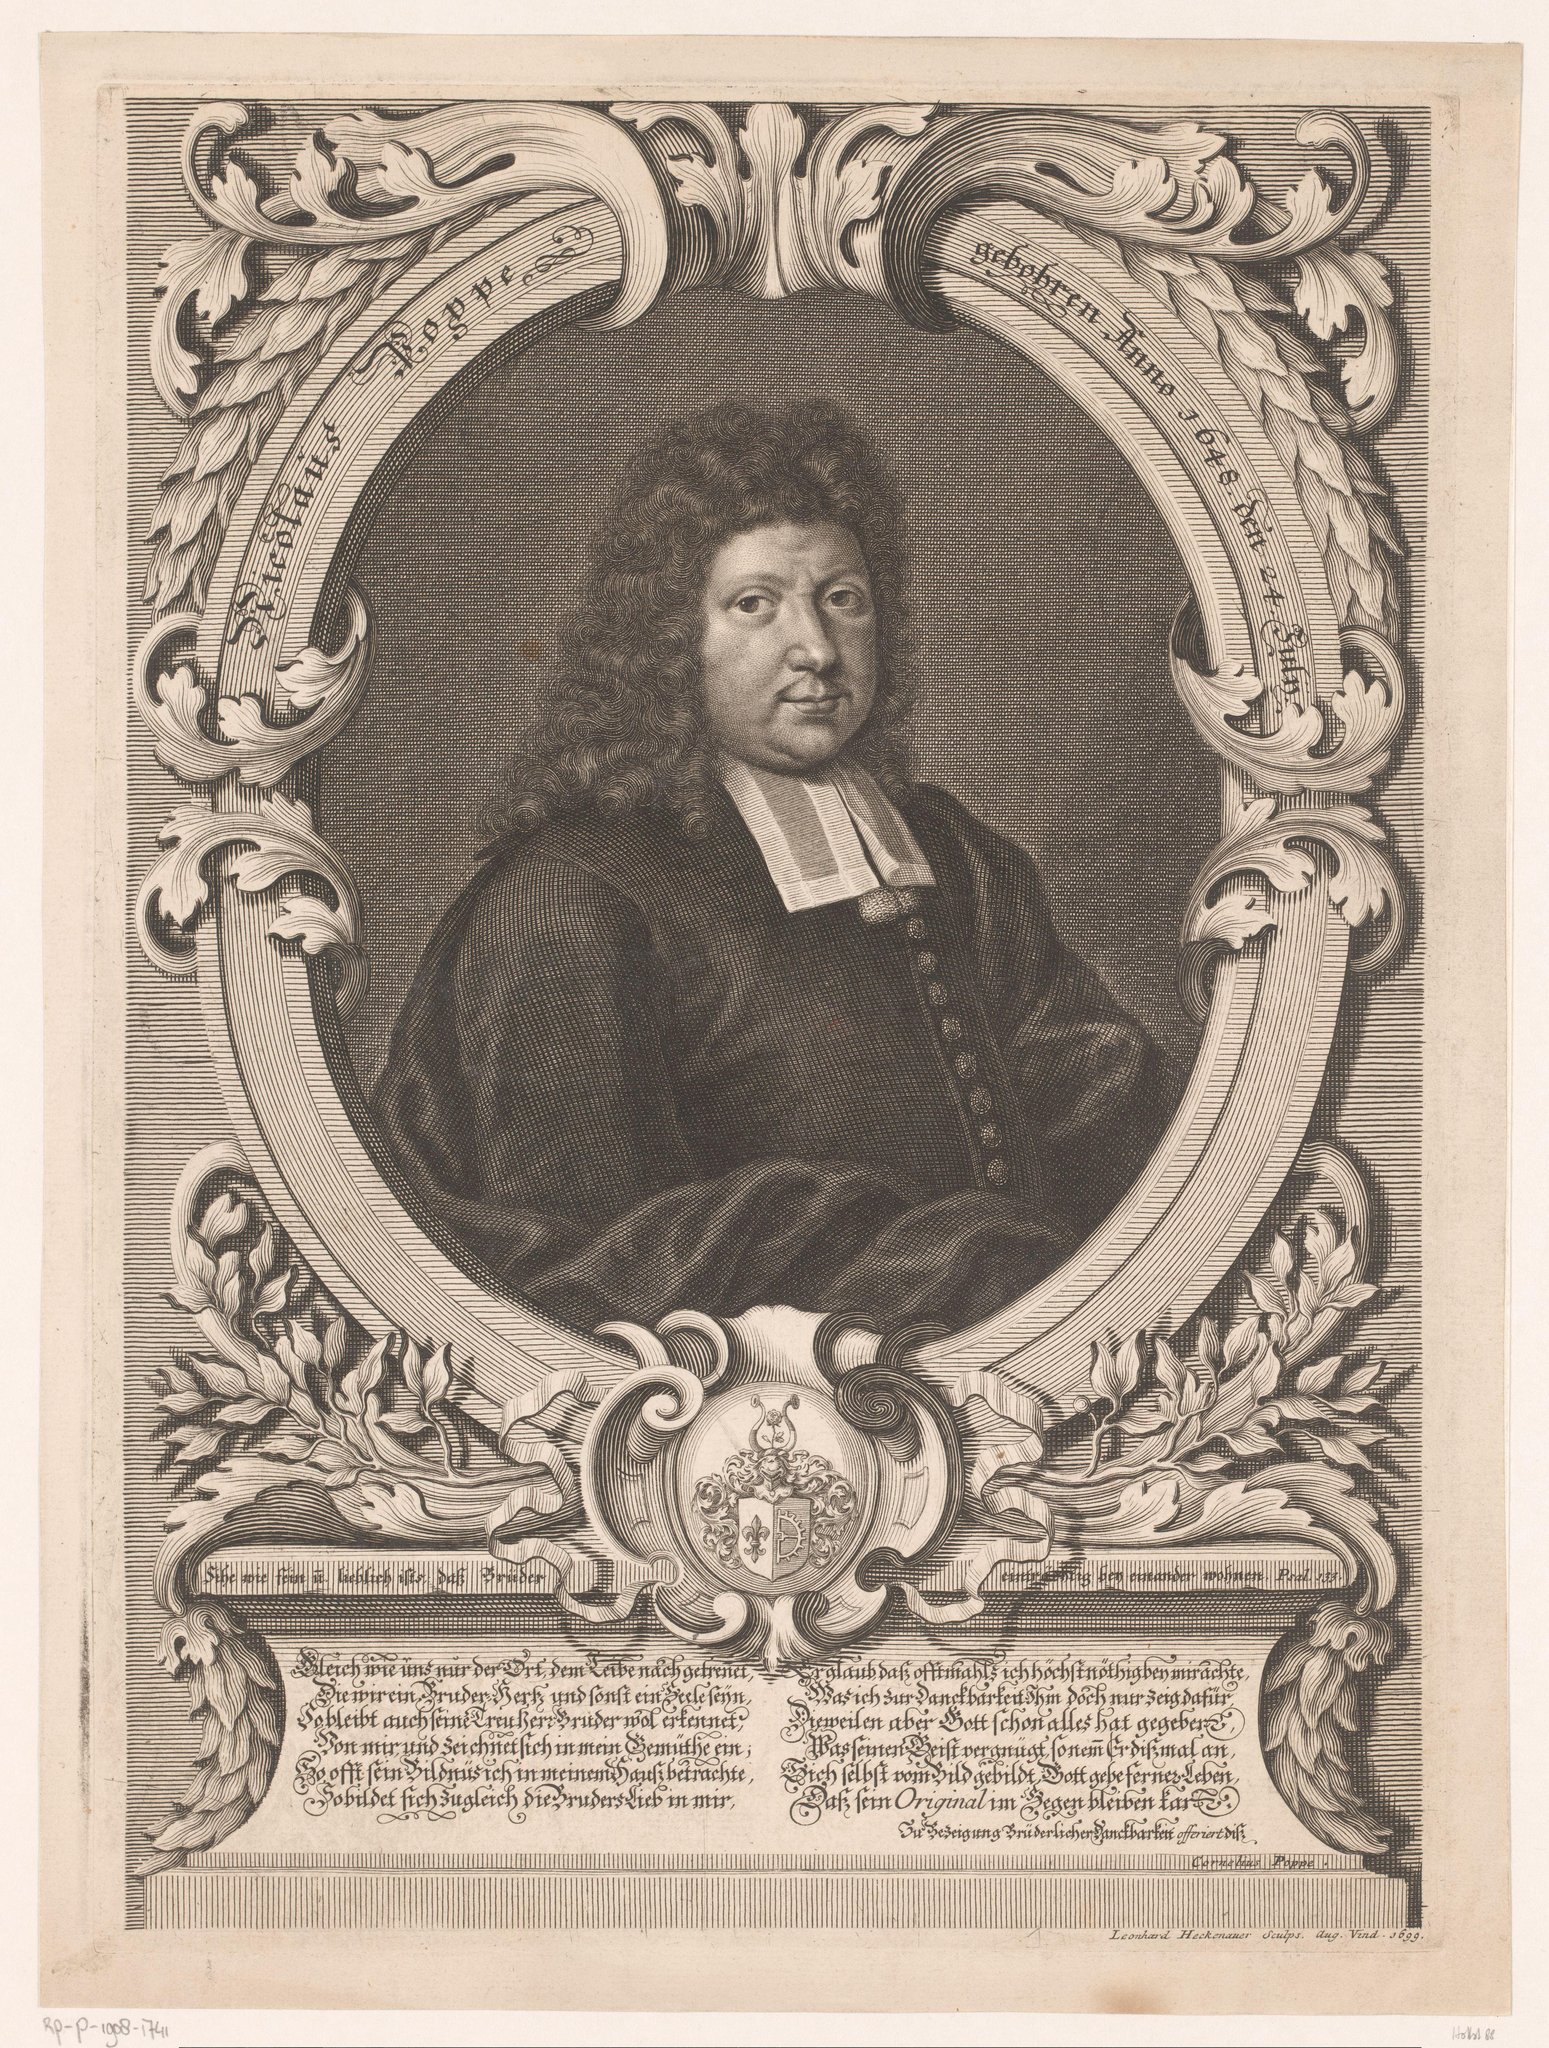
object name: print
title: Portret van Nicolaus Poppe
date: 1699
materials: paper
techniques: engraving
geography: augsburg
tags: trees: laurel (branch, stick), historical persons, ornament ~ cartouche, armorial bearing, heraldry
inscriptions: collector's mark: Lugt 2228